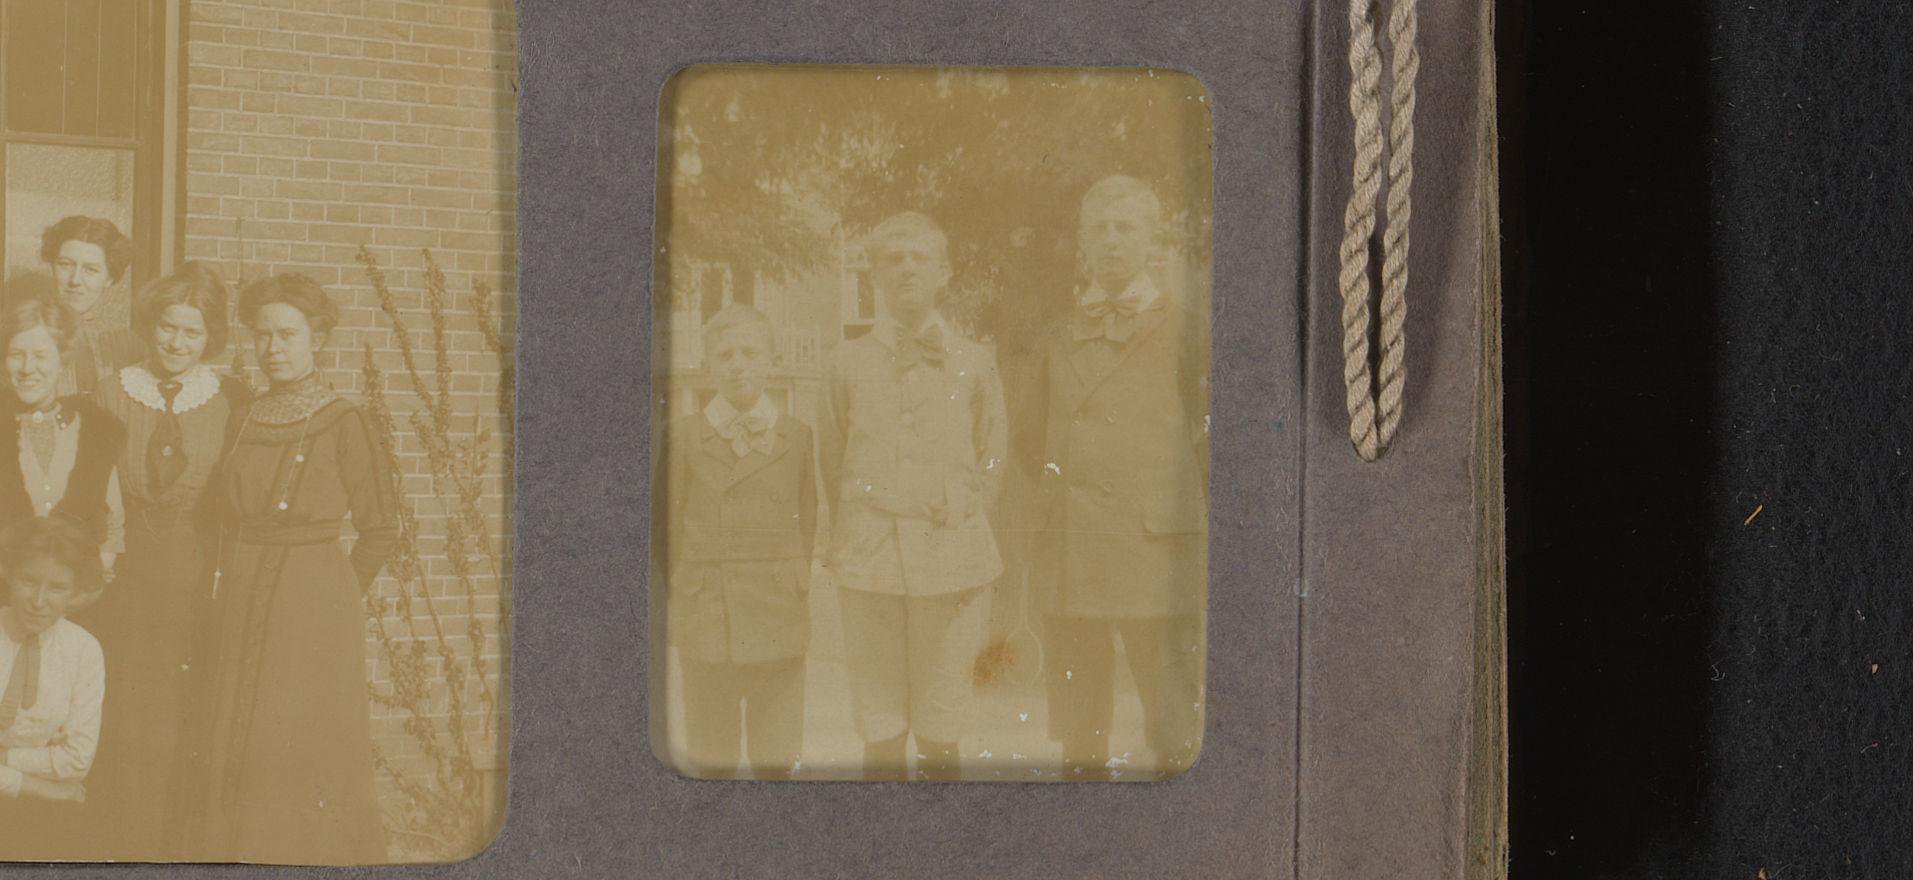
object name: album leaf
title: Drie jongens buiten voor een boom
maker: Anonymous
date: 1908-1912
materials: paper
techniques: gelatin silver print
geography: netherlands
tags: boy (child between toddler and youth), netherlands